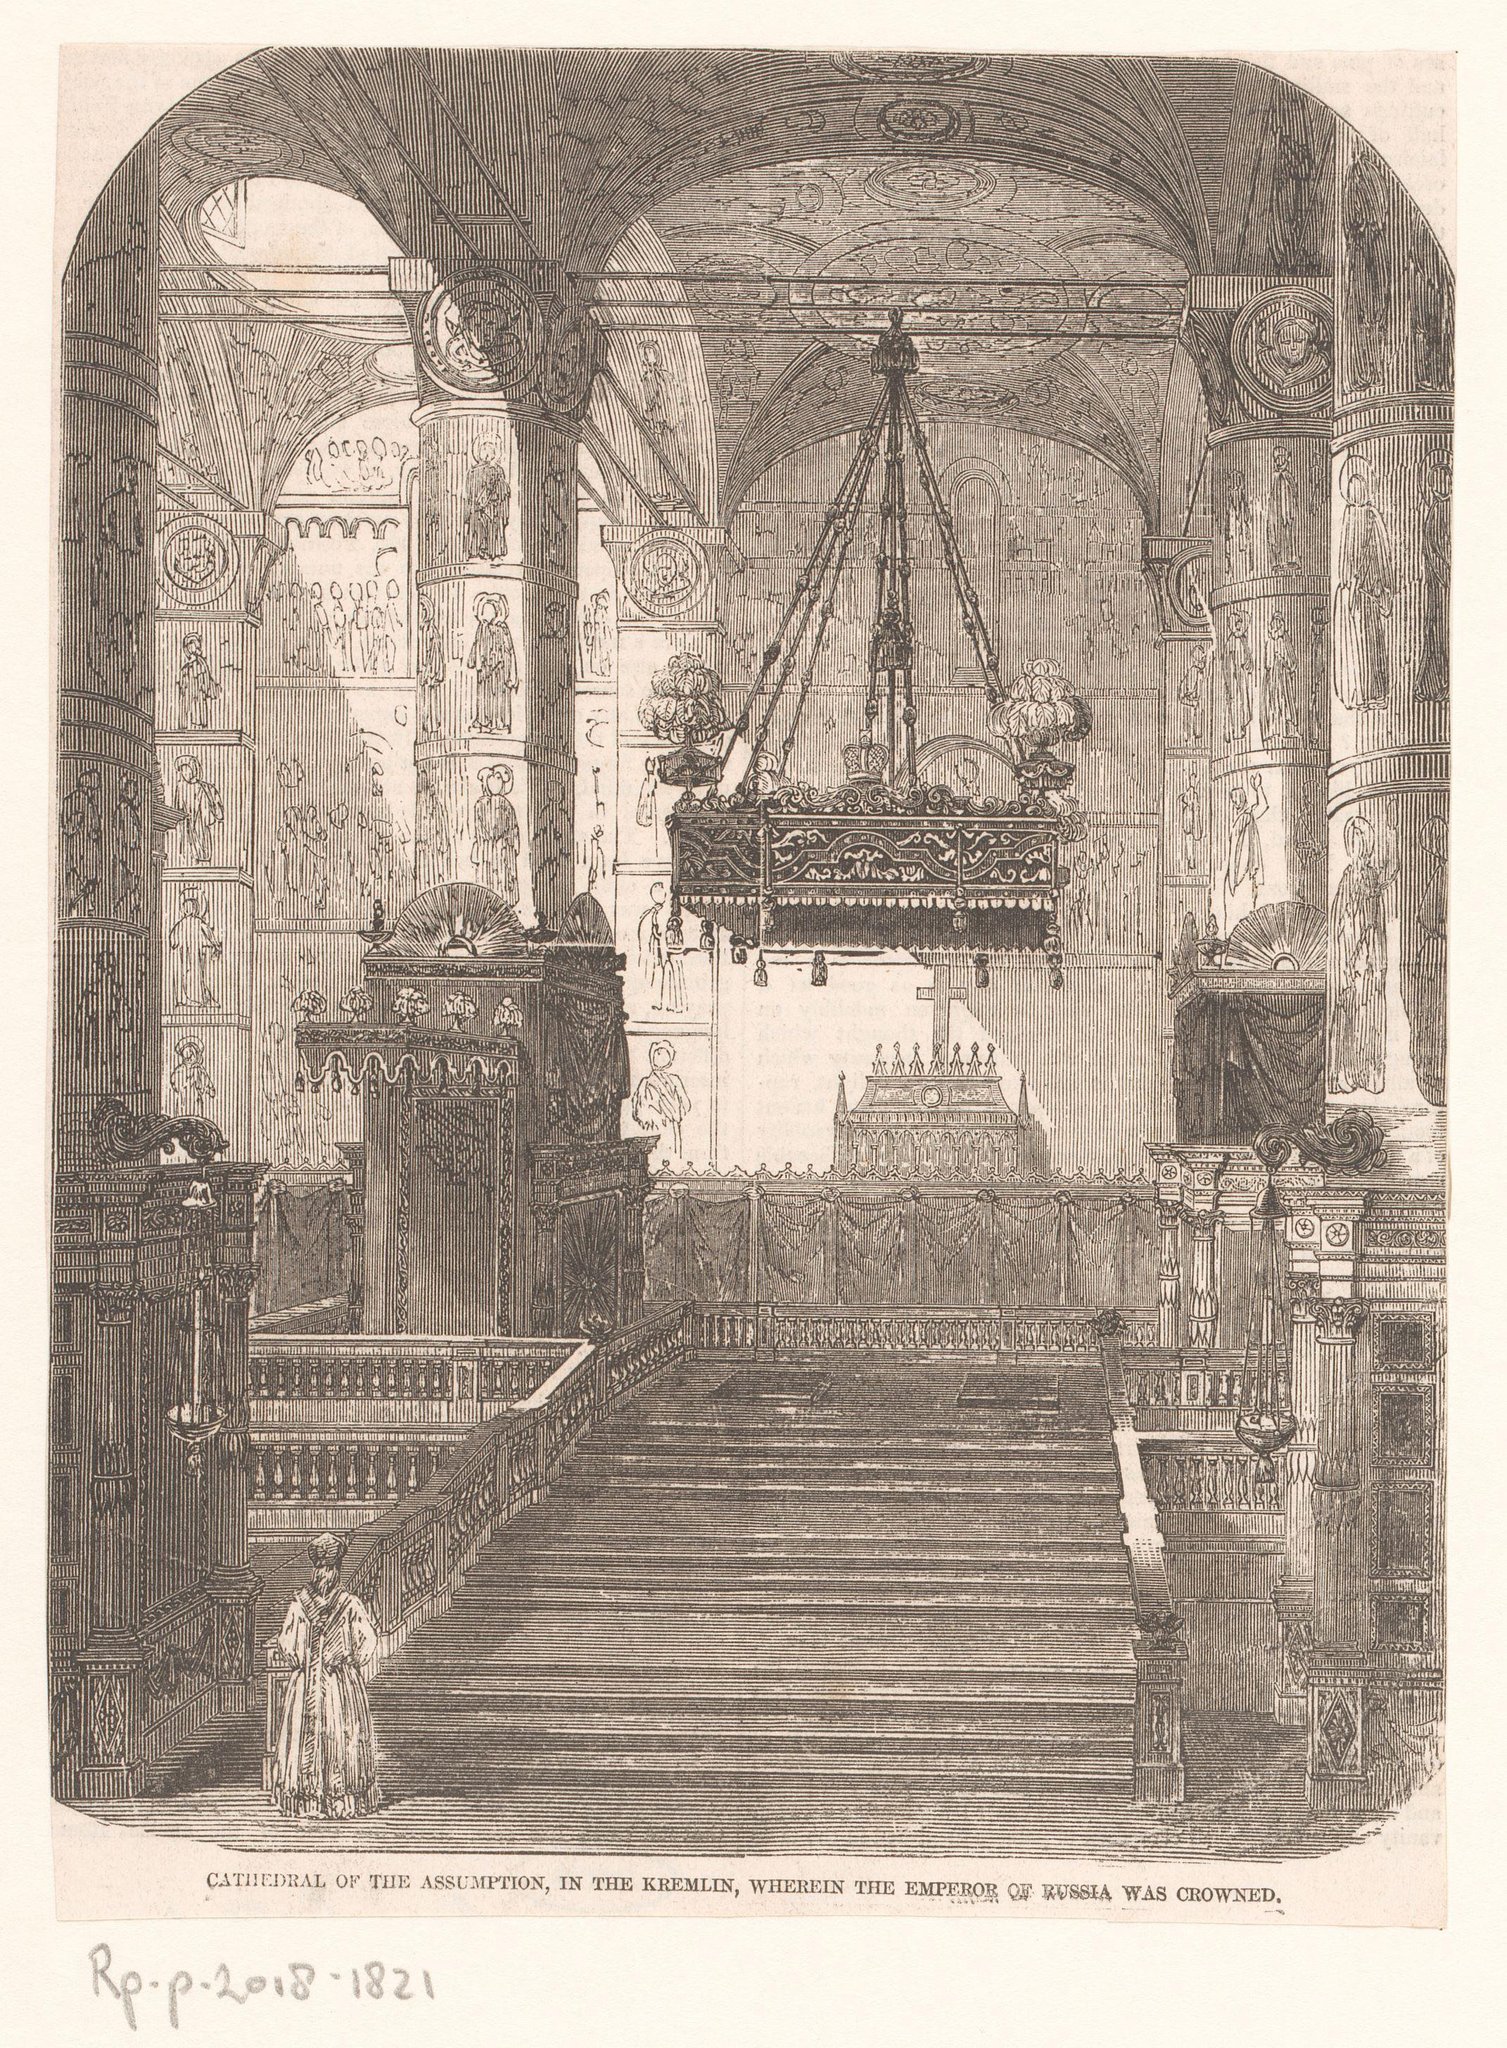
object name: print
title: Cathedral of the Assumption, in the Kremlin, wherein the emperor of Russia was crowned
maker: Anonymous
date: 1856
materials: paper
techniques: letterpress printing, engraving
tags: interior of church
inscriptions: collector's mark: Lugt 2228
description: Prent gebruikt in: The Illustrated London News, 20 september 1856.